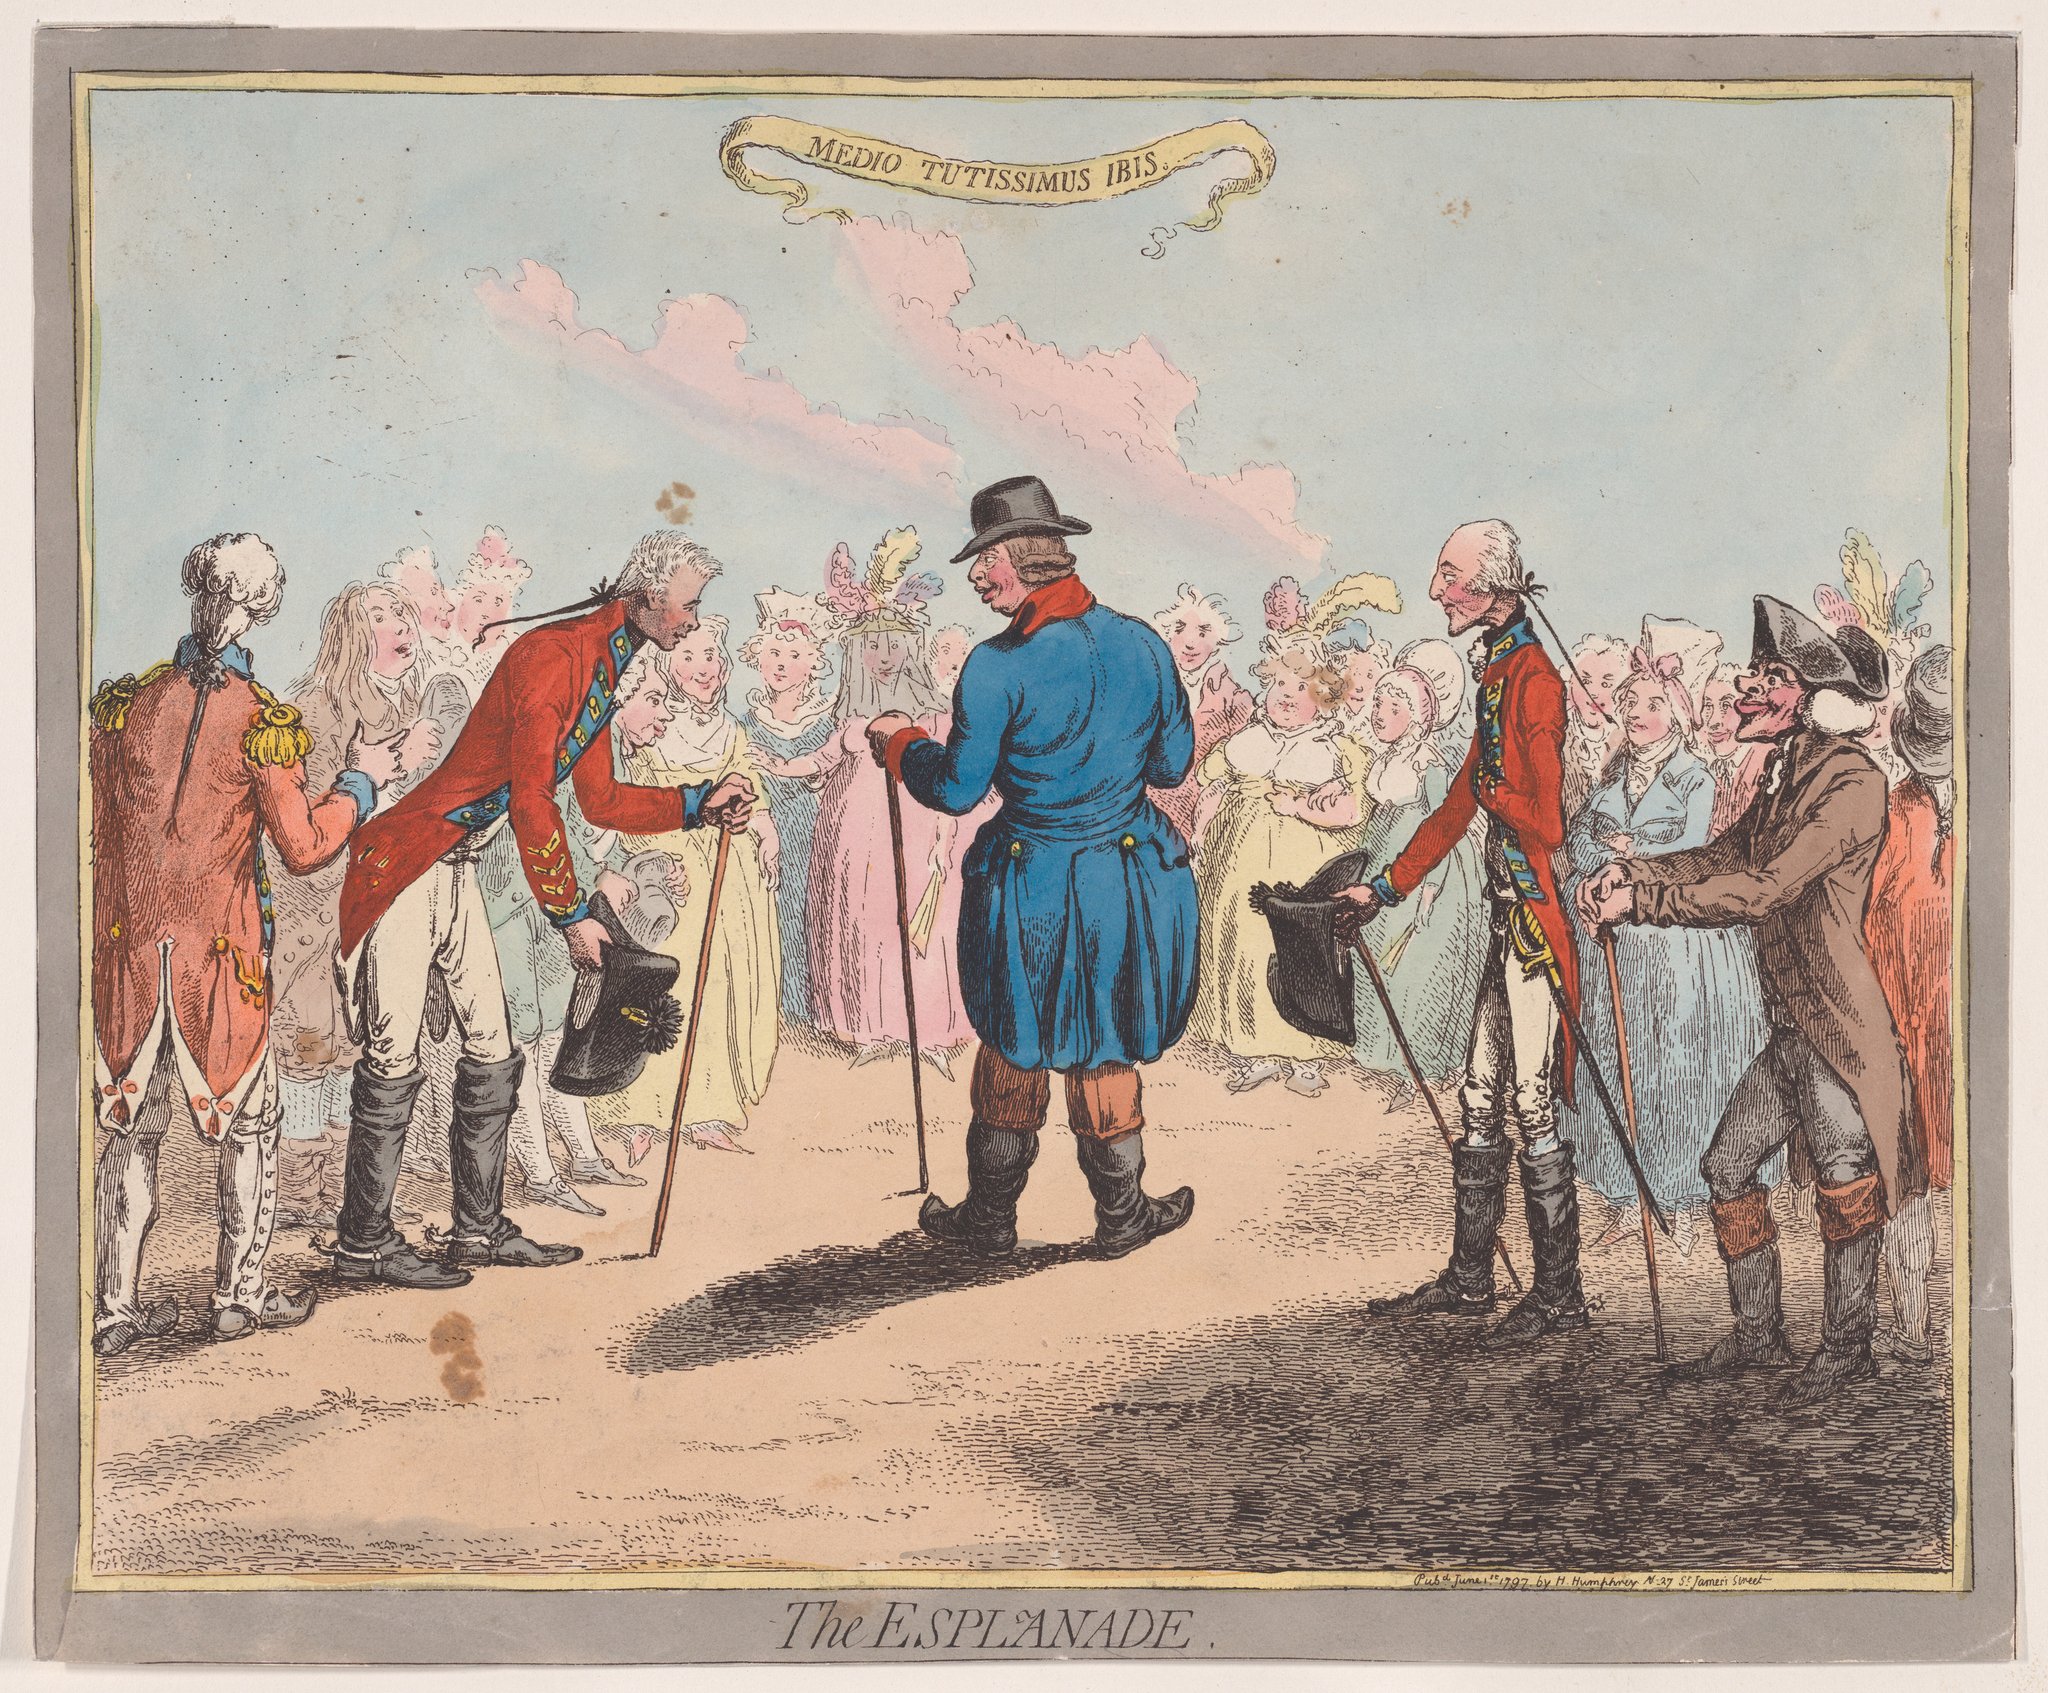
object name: print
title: The Esplanade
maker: james gillray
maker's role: artist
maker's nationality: british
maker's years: 1756-1815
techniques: etching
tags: satire,kings,men,women,george iii